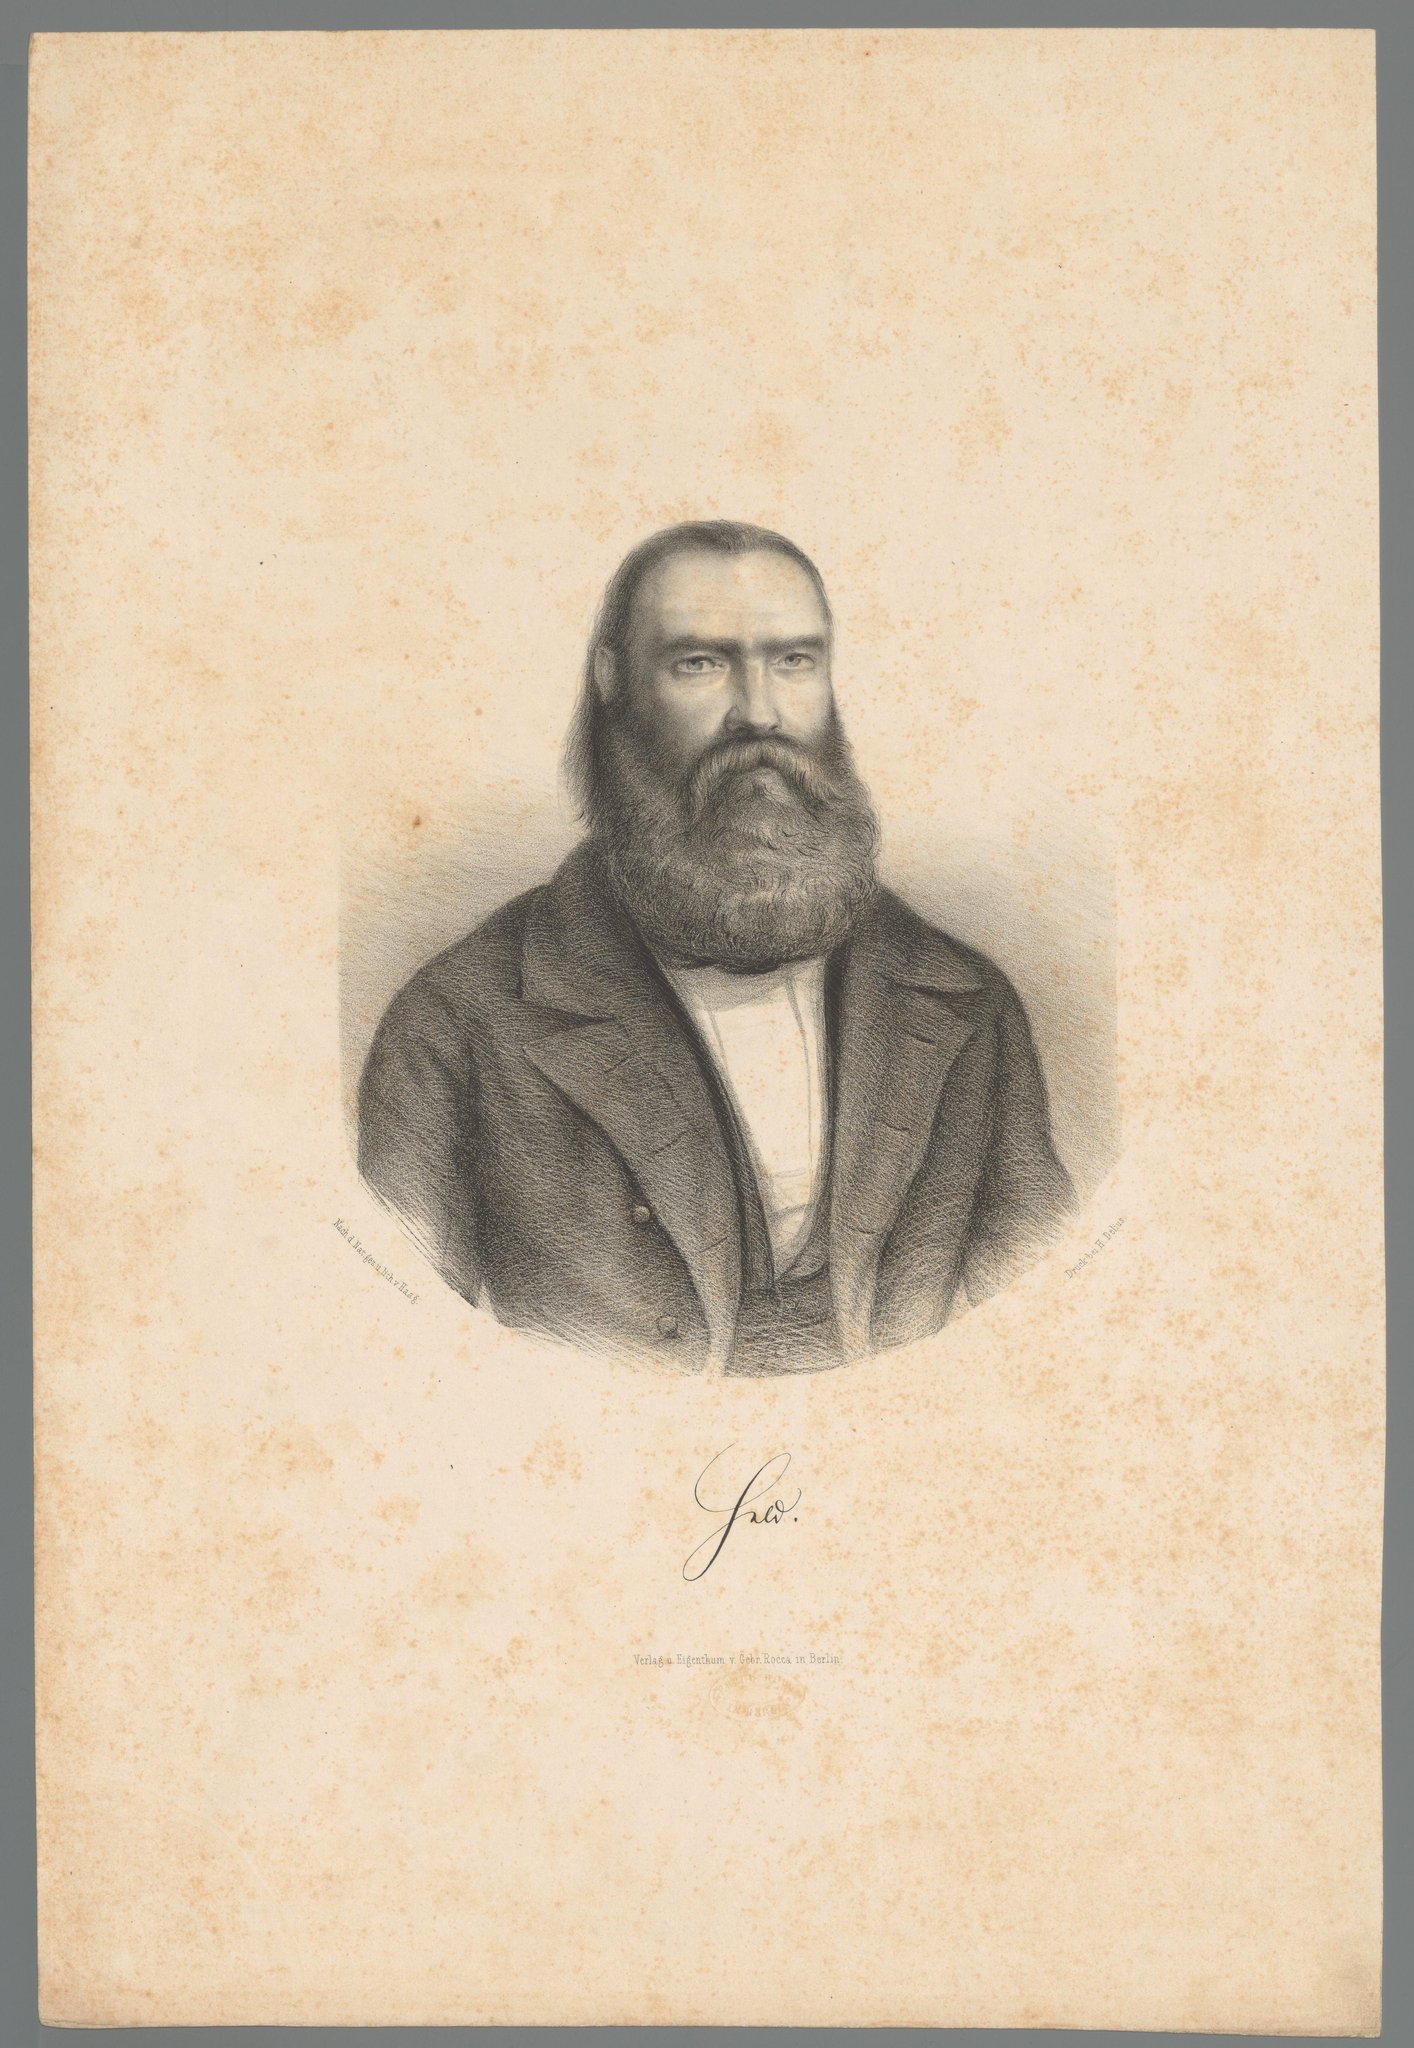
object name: print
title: Portret van een onbekende man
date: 1830-1899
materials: paper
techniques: lithograph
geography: berlin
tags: adult man, historical persons, beard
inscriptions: check stamp: Lugt 2141c, collector's mark: Lugt 2228